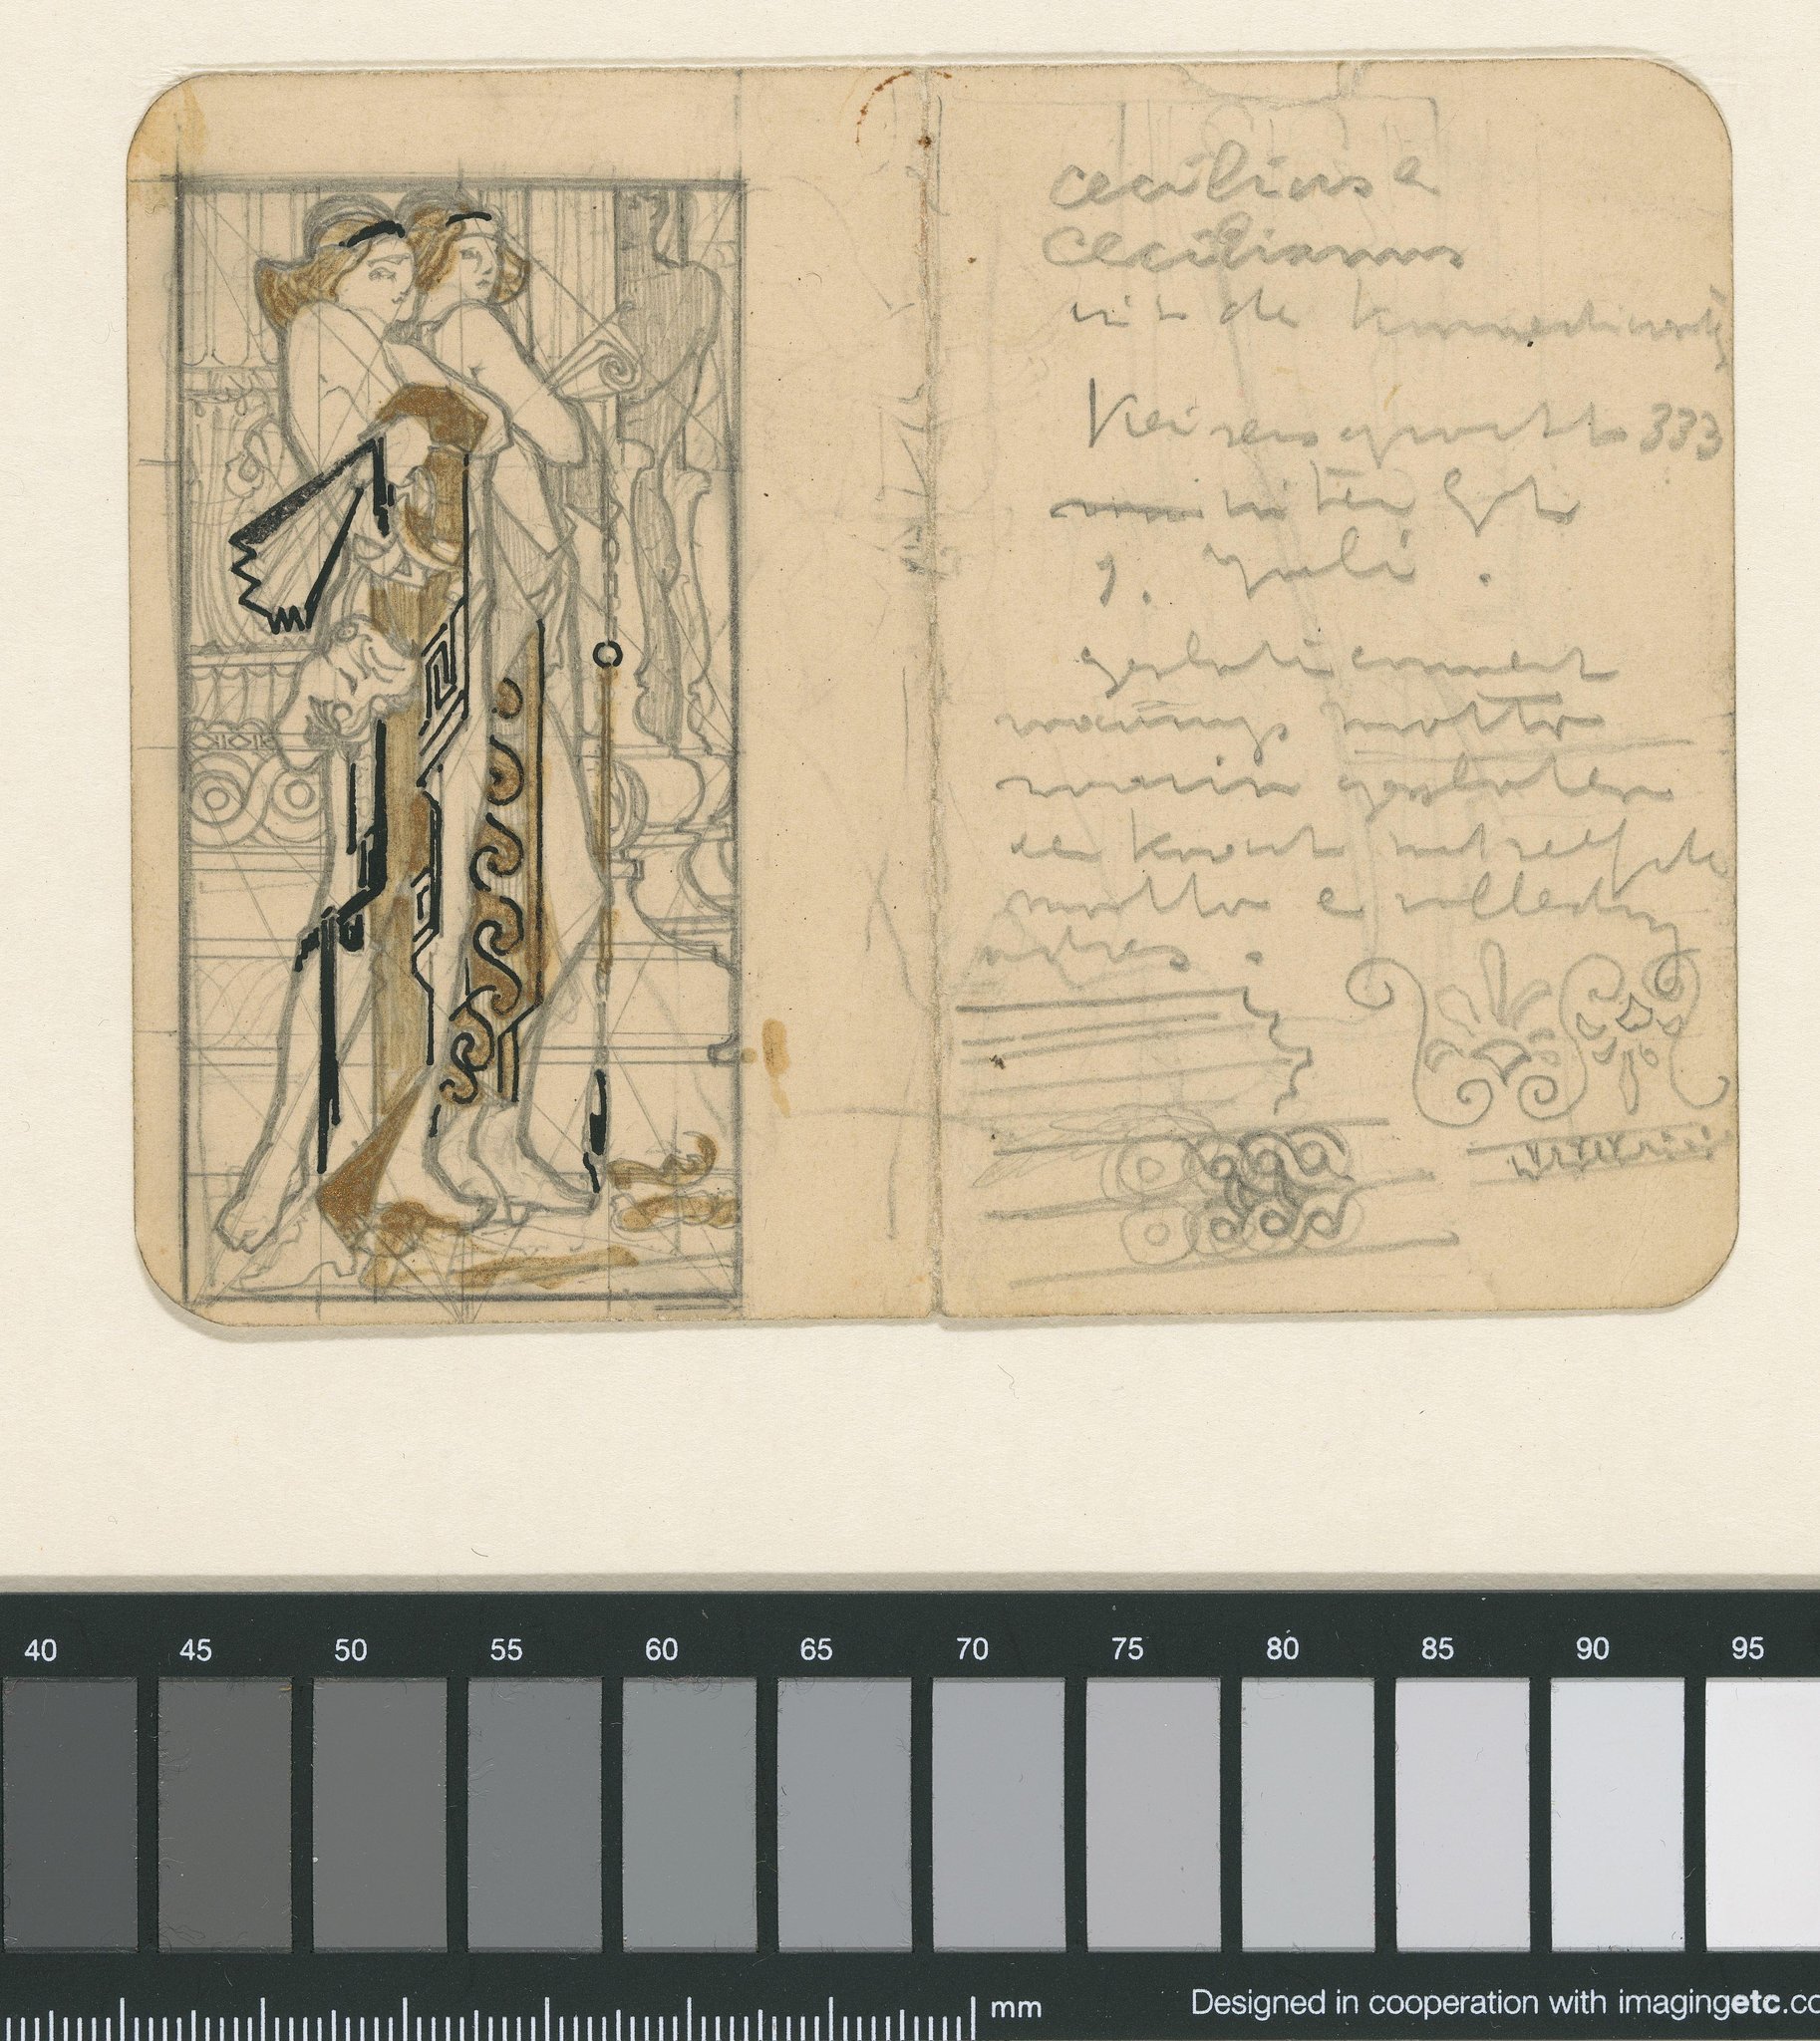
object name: drawing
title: Twee staande vrouwen en tekst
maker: reijer stolk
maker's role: draughtsman, print maker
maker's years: 1896-1945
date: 1906-1945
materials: paint, ink, paper, pencil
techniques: pen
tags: standing figure - aa - female human figure